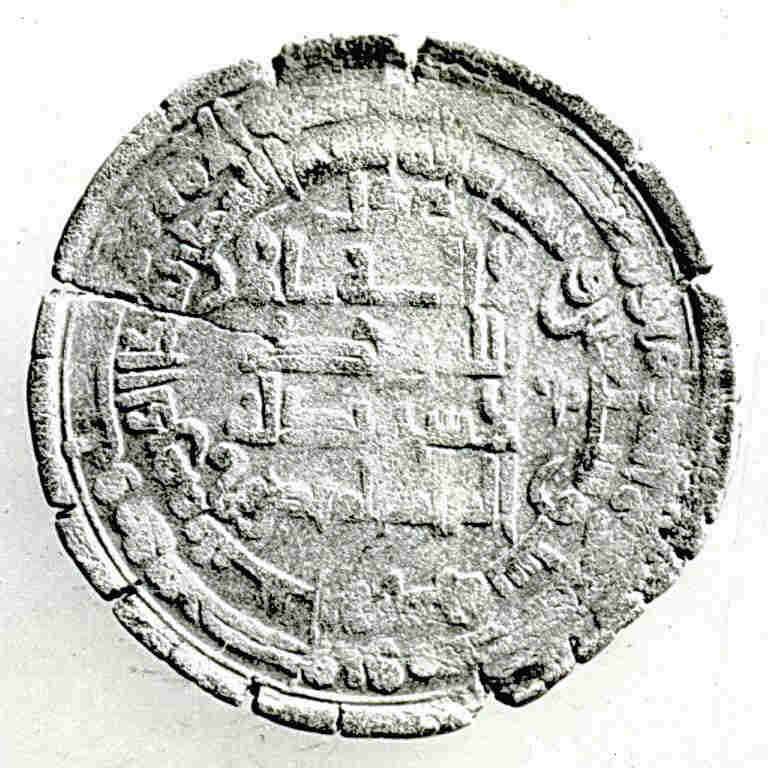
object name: coin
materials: silver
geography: iran